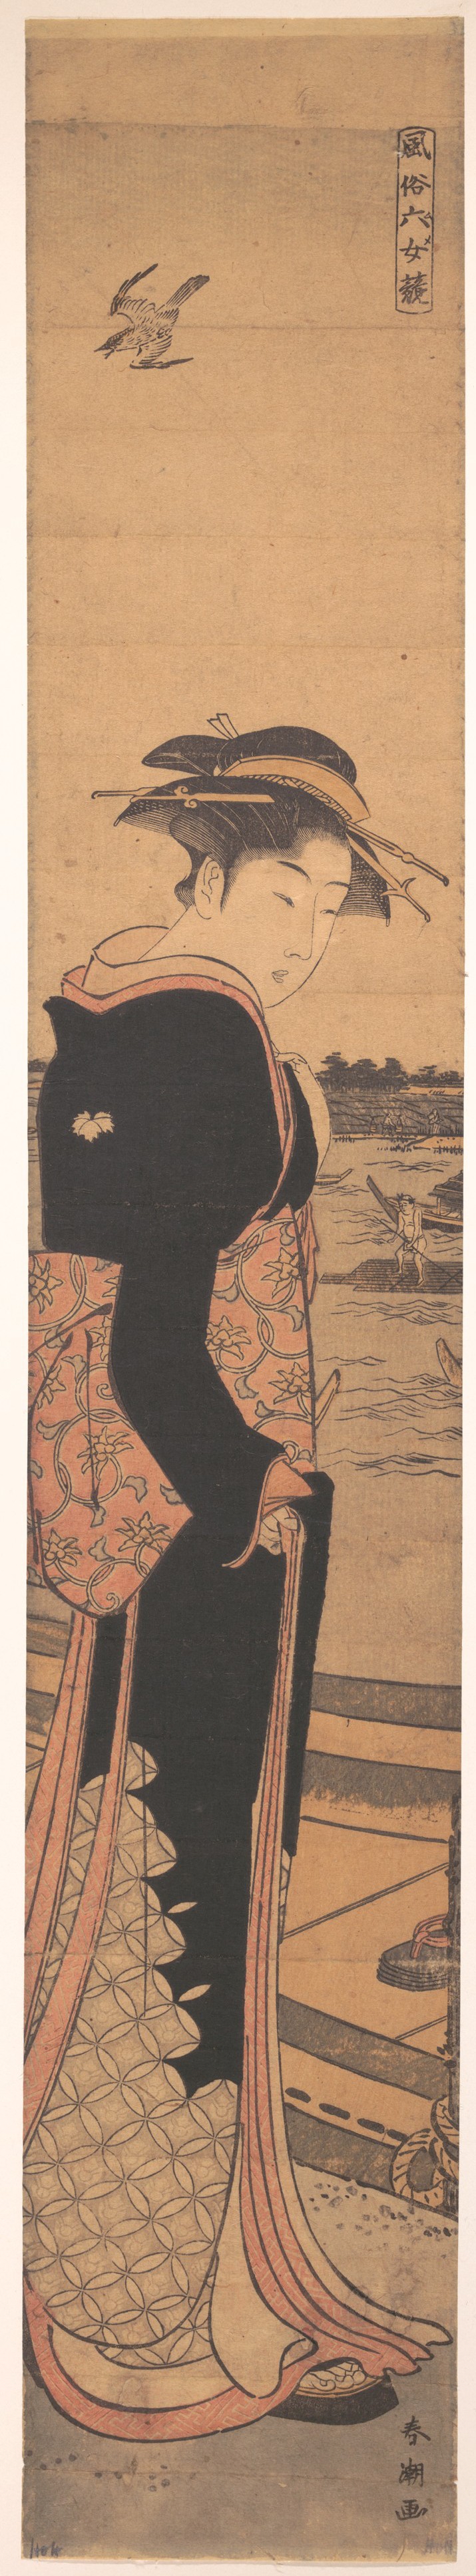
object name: print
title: Young Lady by the Shore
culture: japanese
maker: katsukawa shunchō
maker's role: artist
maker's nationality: japanese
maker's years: 1775-1795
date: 1780-1795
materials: ink, paper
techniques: woodblock print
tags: birds,women